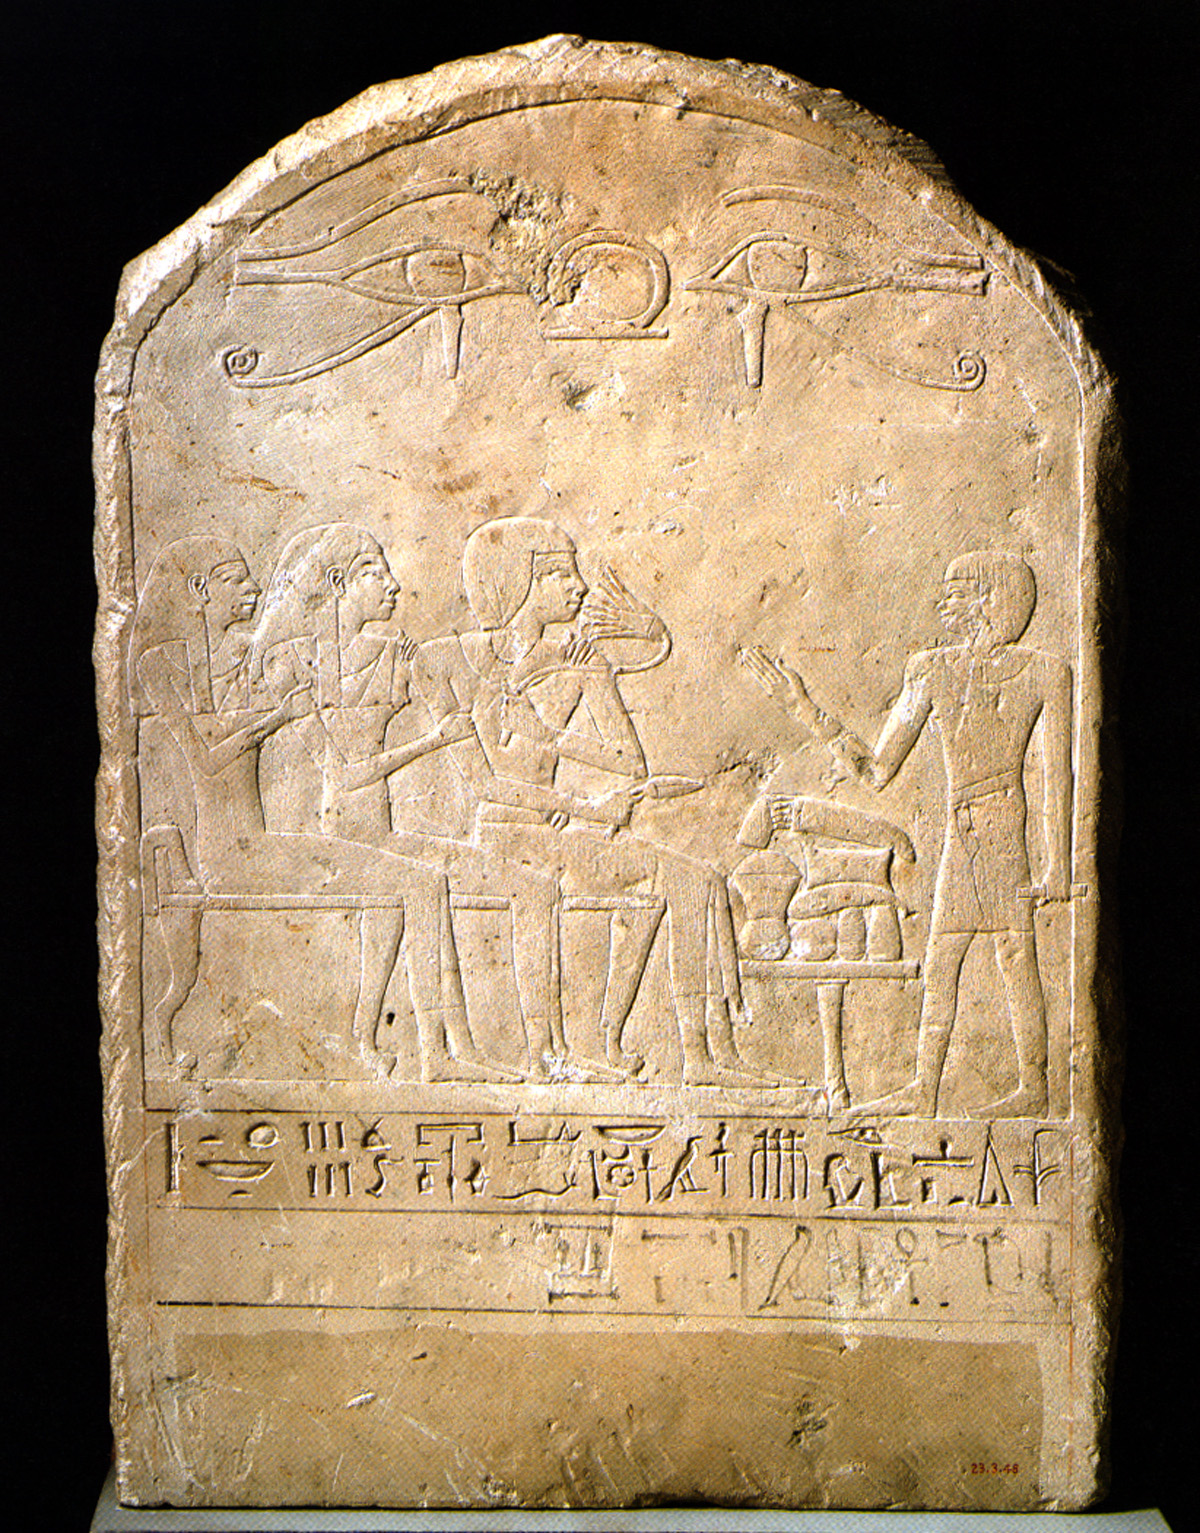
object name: stela, unfinished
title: Unfinished Funerary Stela for a Family, Space Left Blank for Name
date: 1479-1458 BCE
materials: limestone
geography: egypt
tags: eyes,men,women,hieroglyphs